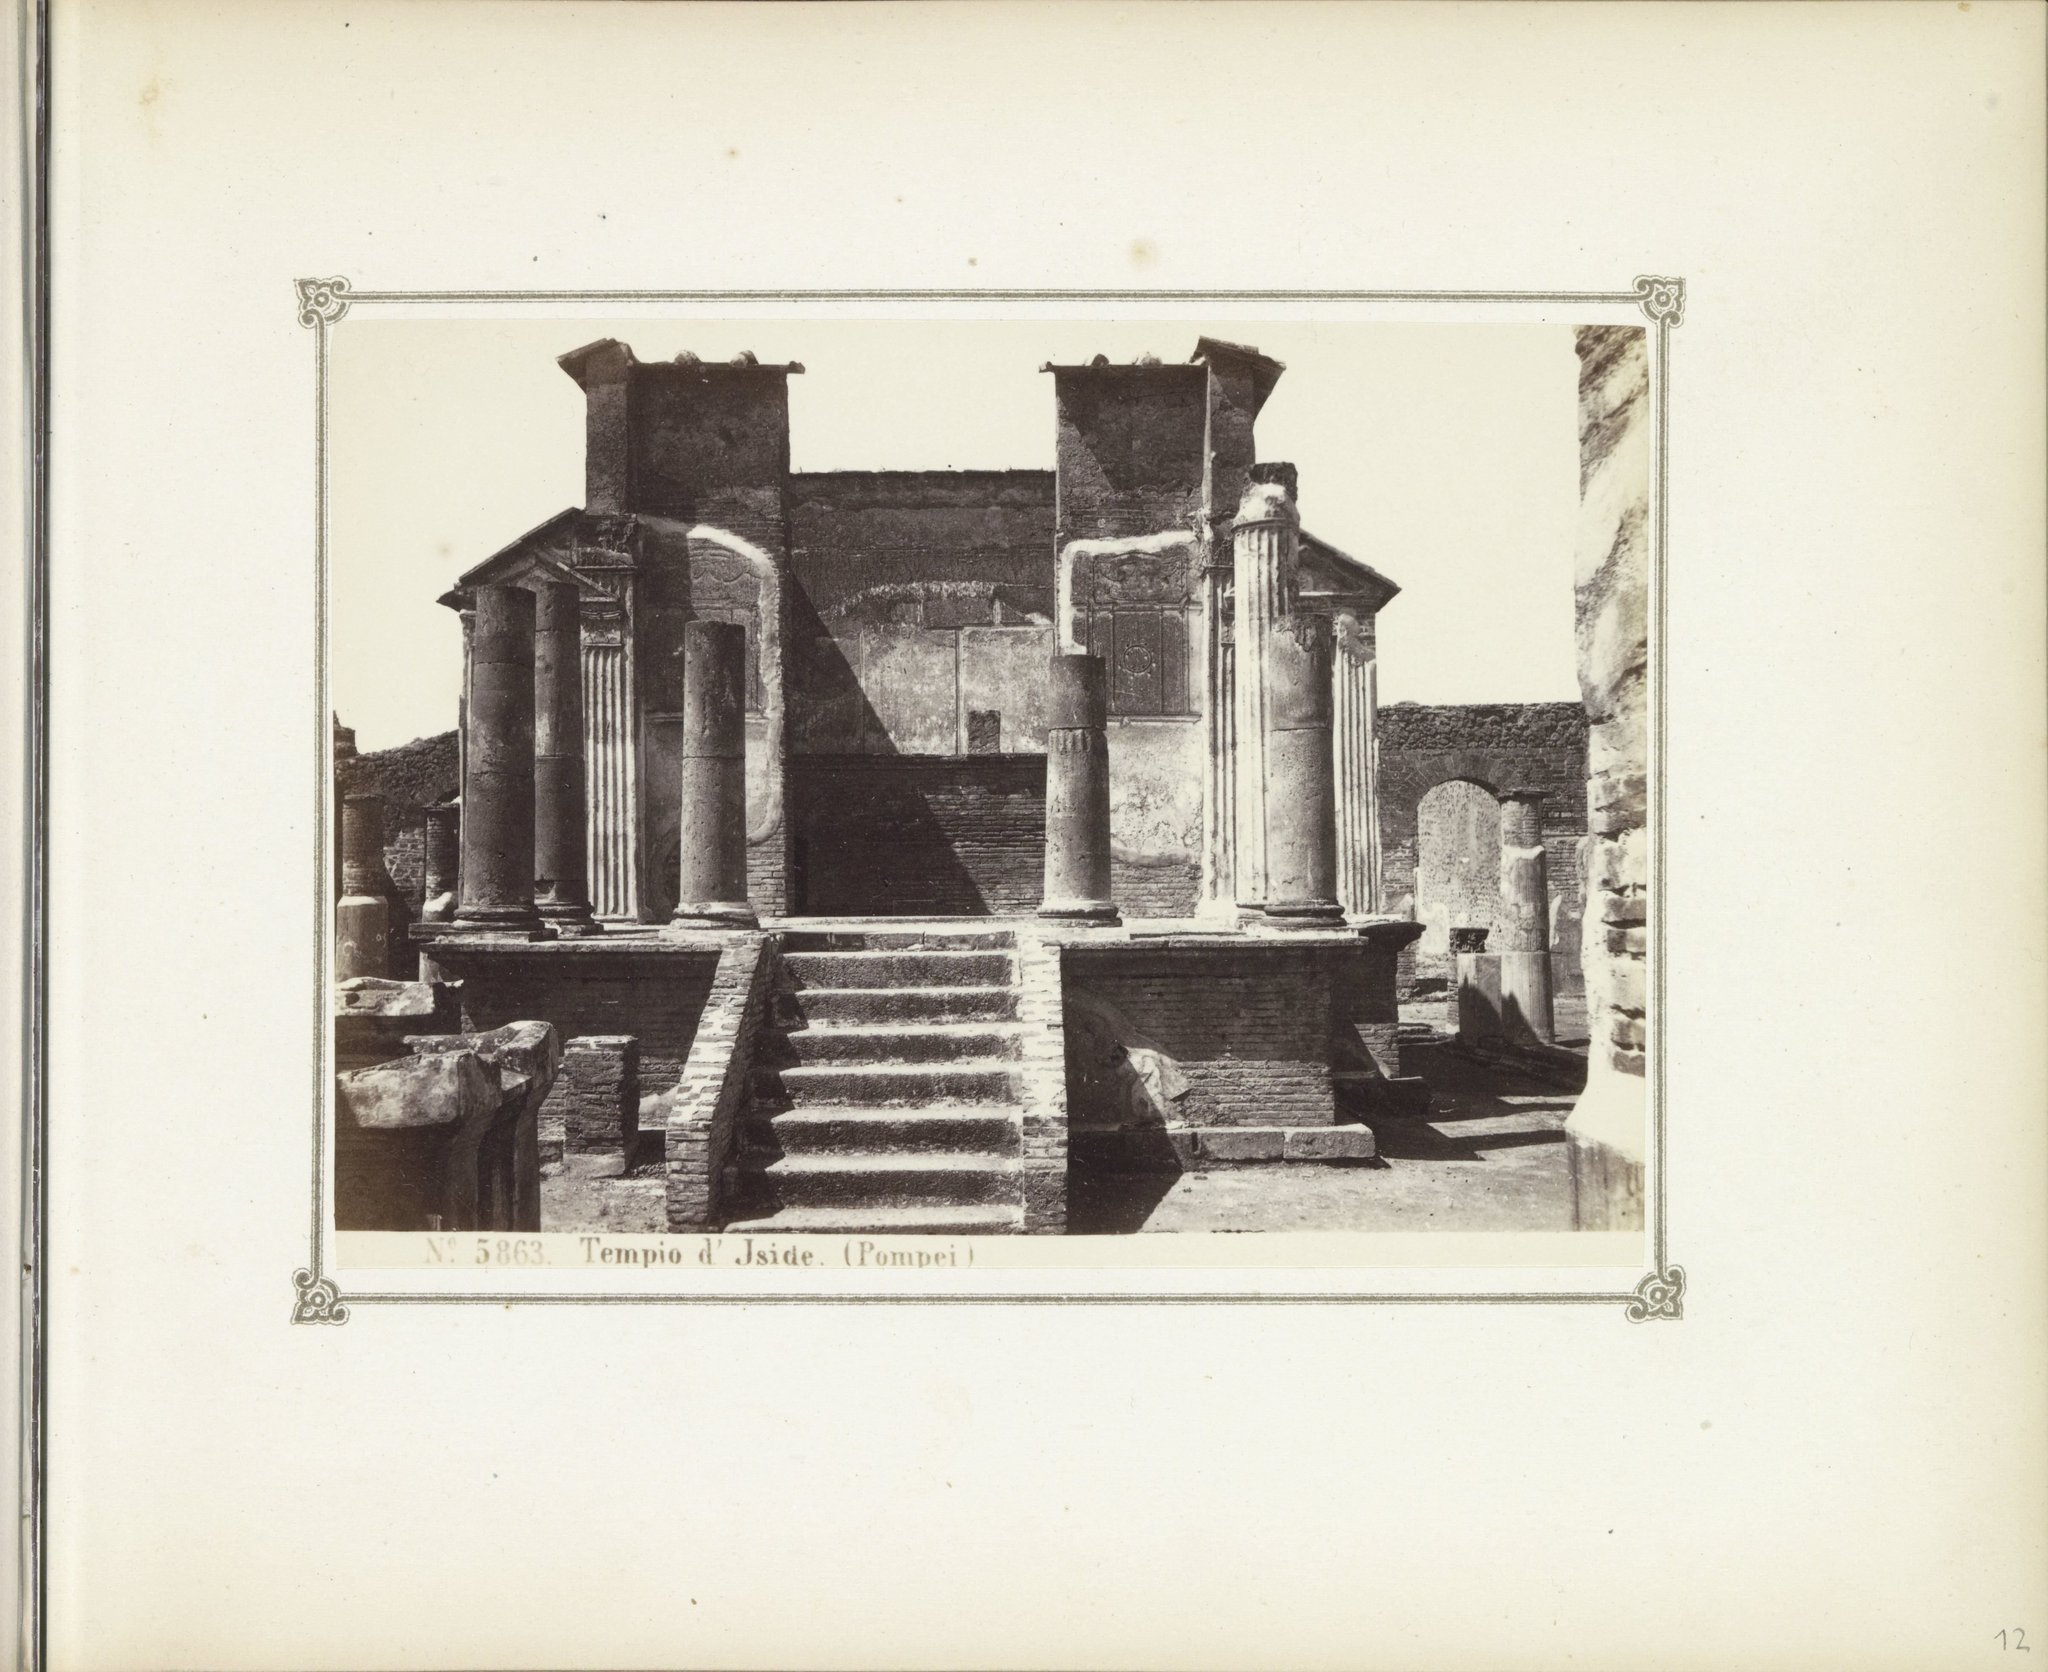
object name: album leaf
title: Tempio d' Jside. (Pompei)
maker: giorgio sommer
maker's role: fotograaf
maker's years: 1834-1914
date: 1860-1900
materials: paper, photographic support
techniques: albumen print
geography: pompeii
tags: temple, shrine ~ roman religion, excavation ~ archaeology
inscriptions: number: ‘5863’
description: Onderdeel van Fotoalbum met opnames van opgravingen in Pompeï door Giorgio Sommer.